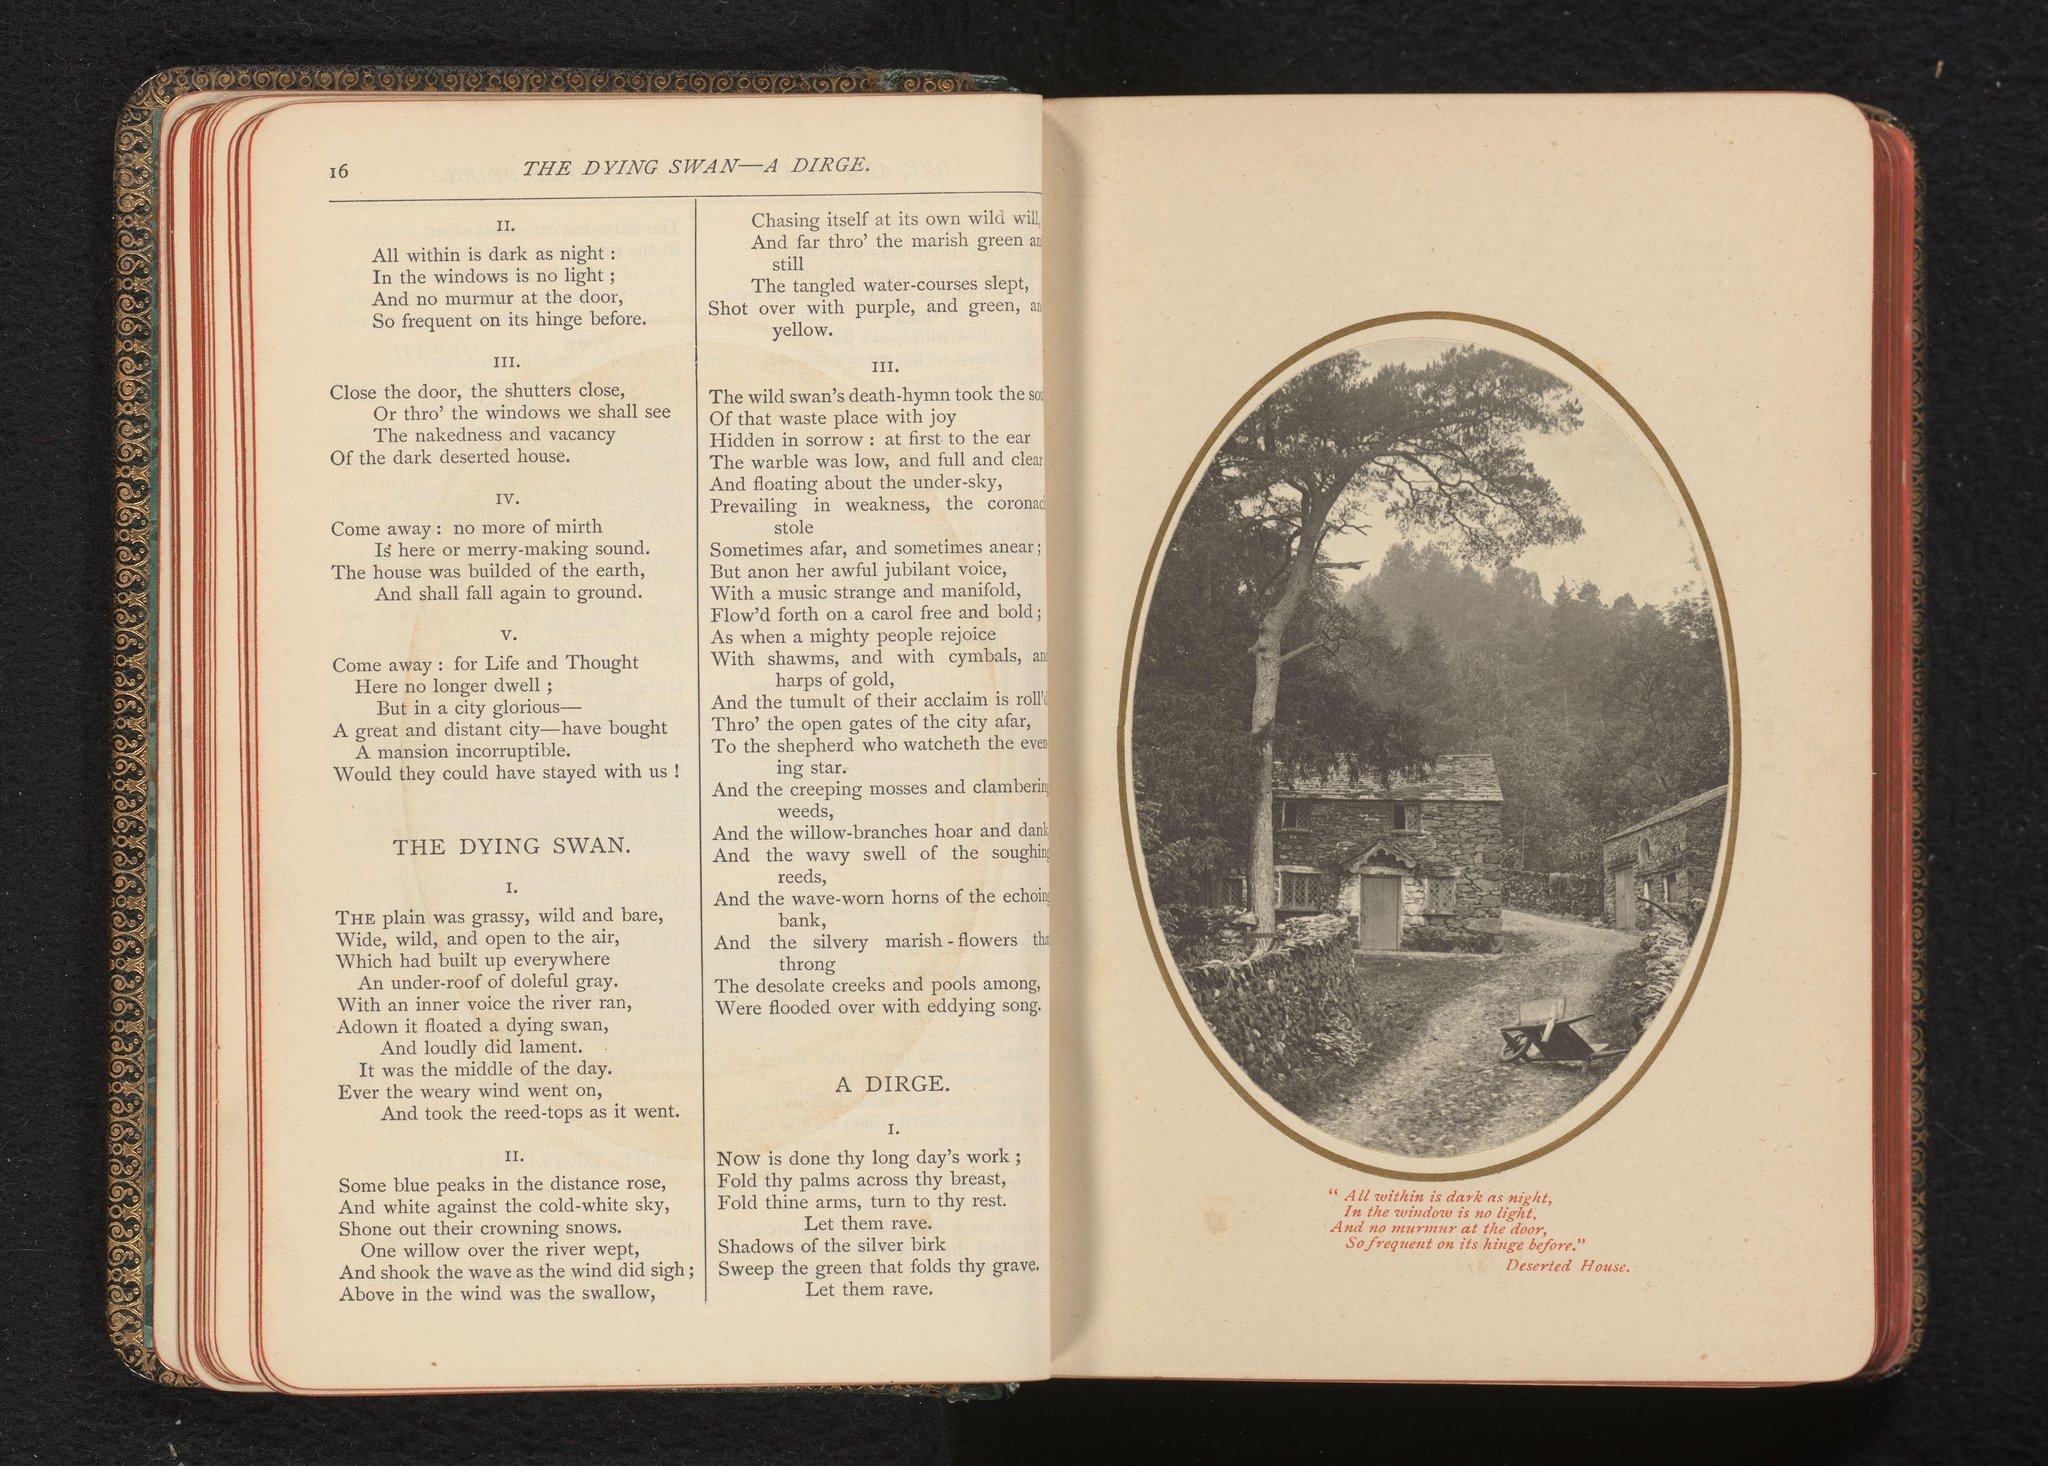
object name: page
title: Huis aan een bosrand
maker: john payne jennings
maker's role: fotograaf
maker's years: 1843-1926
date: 1895-1900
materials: paper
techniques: platinum process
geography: great britain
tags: cottage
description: Foto op ongenummerde pagina tegenover pagina 16.